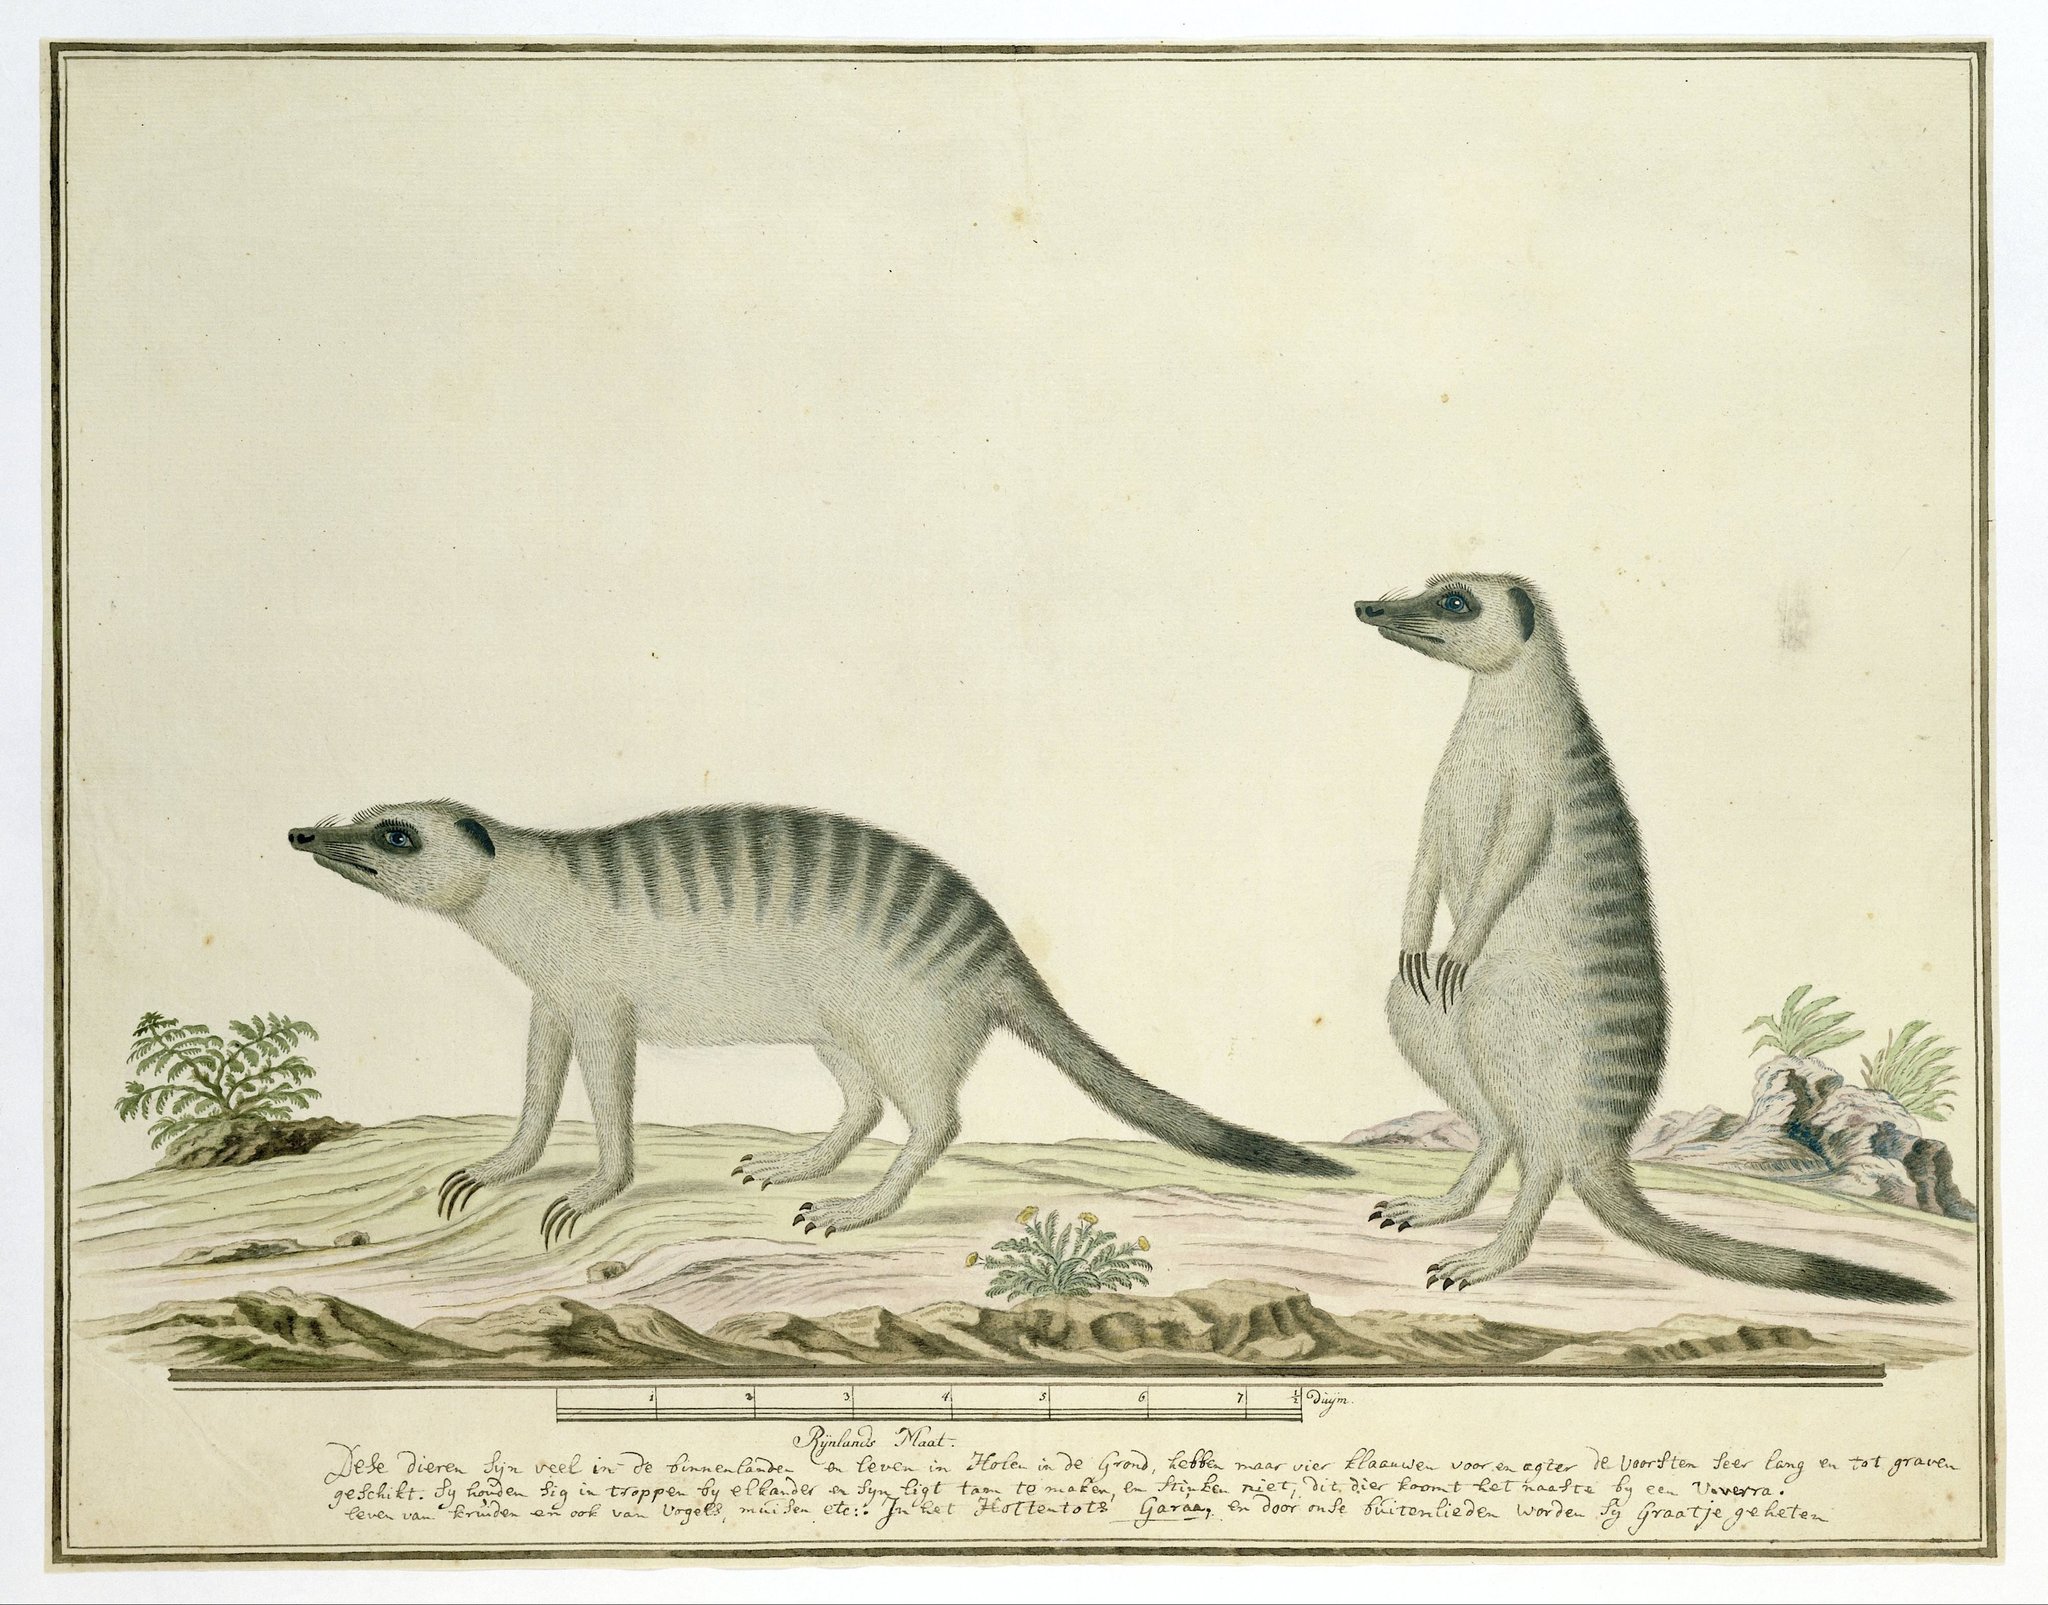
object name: drawing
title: Suricata suricatta (Meerkats)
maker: robert jacob gordon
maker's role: draughtsman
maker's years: 1743-1795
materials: paint, ink, paper, pencil, watercolor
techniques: brush, pen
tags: animals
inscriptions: annotation: ‘schaalverdeling, daaronder 'Rijnlandse Maat', met 'Voet' en rechts aan eind 'Duijm' / dese dieren sijn veel in de binnenlanden en leven in Holen in de Grond, hebben maar vier klaauwen voor en agter de voorsten seer lang en tot graven/[.....]/ In het Hottentots Garaaq [onderstreept] en door onse buitenlieden worden Sij Graatje geheten’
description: Twee stokstaartjes (Suricata suricatta), ook wel Graatje genoemd, in het Khoikhoi Garaaq; met schaalverdeling in Rijnlandse maat.